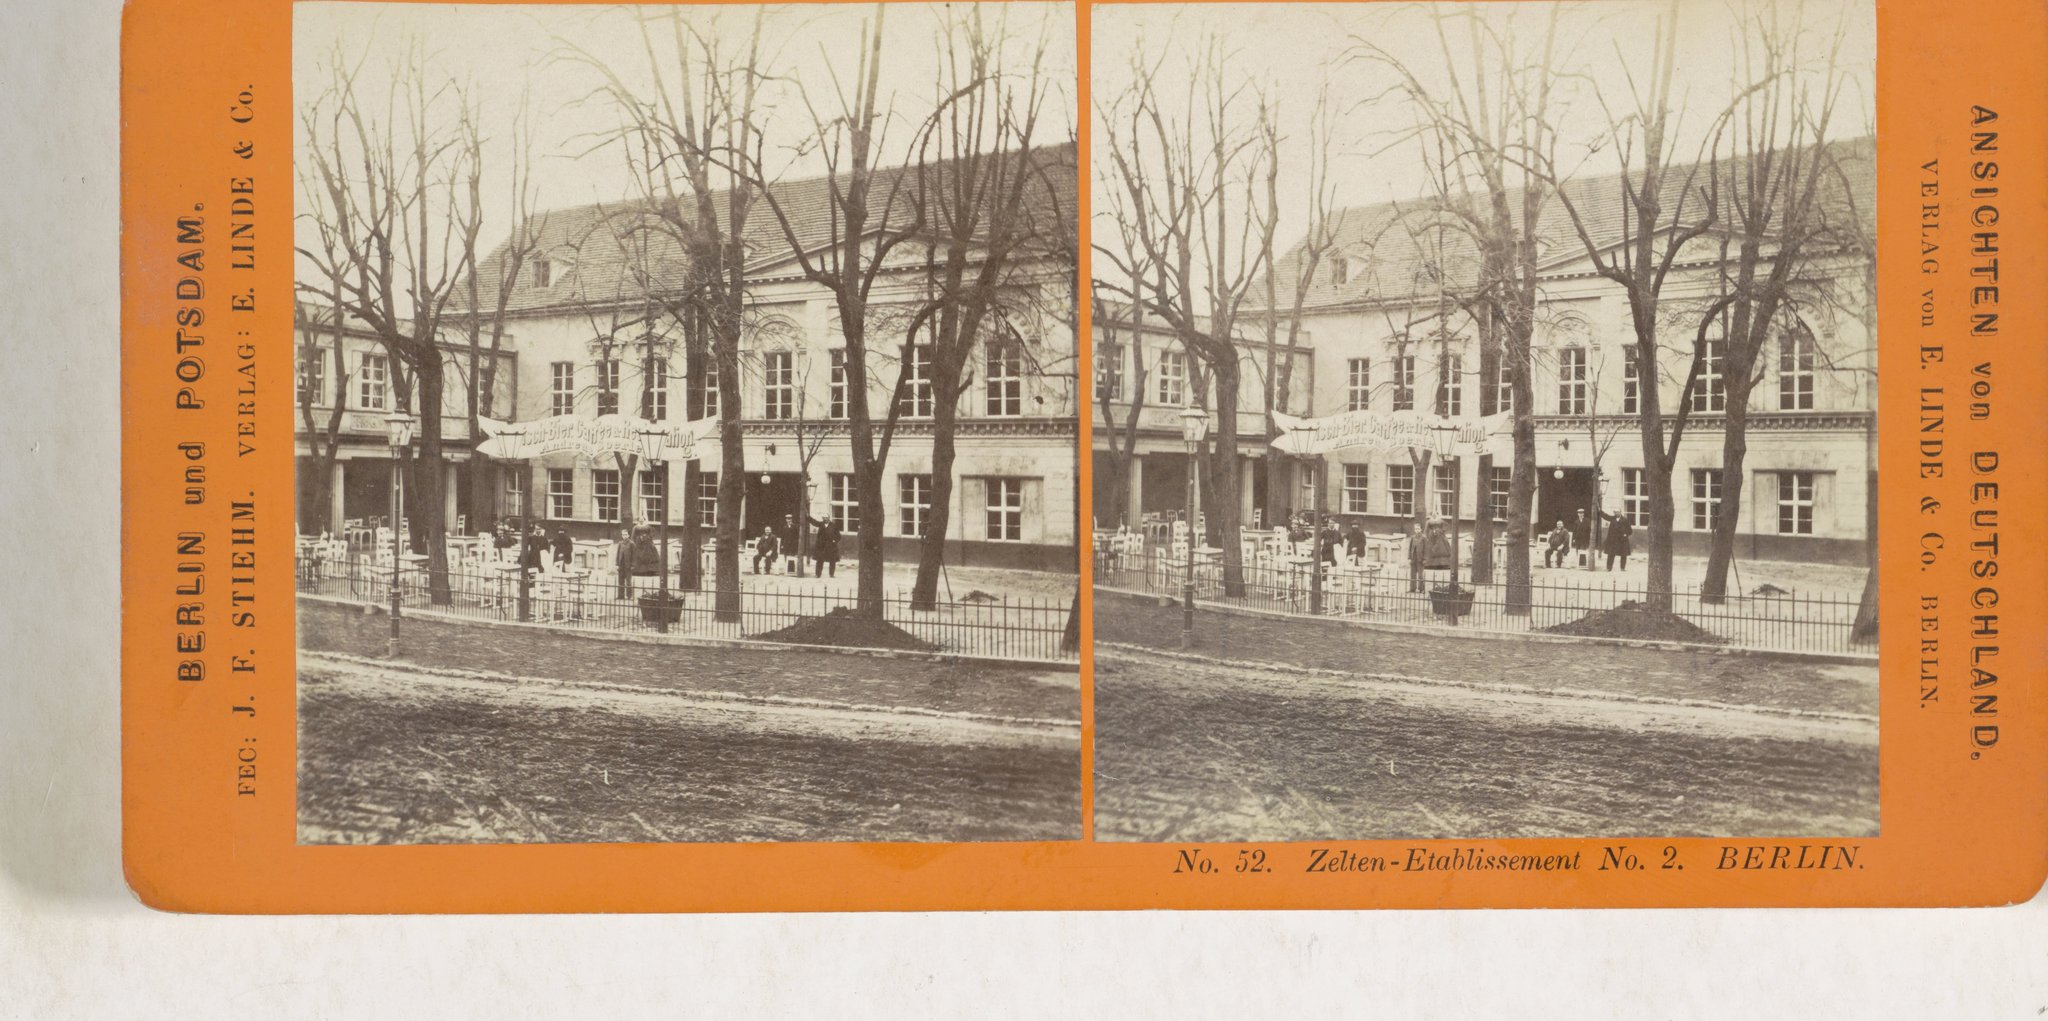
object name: stereograph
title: Zelten-Etablissement No. 2. Berlin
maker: johann friedrich stiehm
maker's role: fotograaf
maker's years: 1826-1902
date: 1868-1870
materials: cardboard, paper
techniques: albumen print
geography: großer tiergarten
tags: tea garden, garden restaurant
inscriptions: number: ‘No. 52.’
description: Tegenwoordig staat op deze locatie het Haus der Kulturen der Welt.